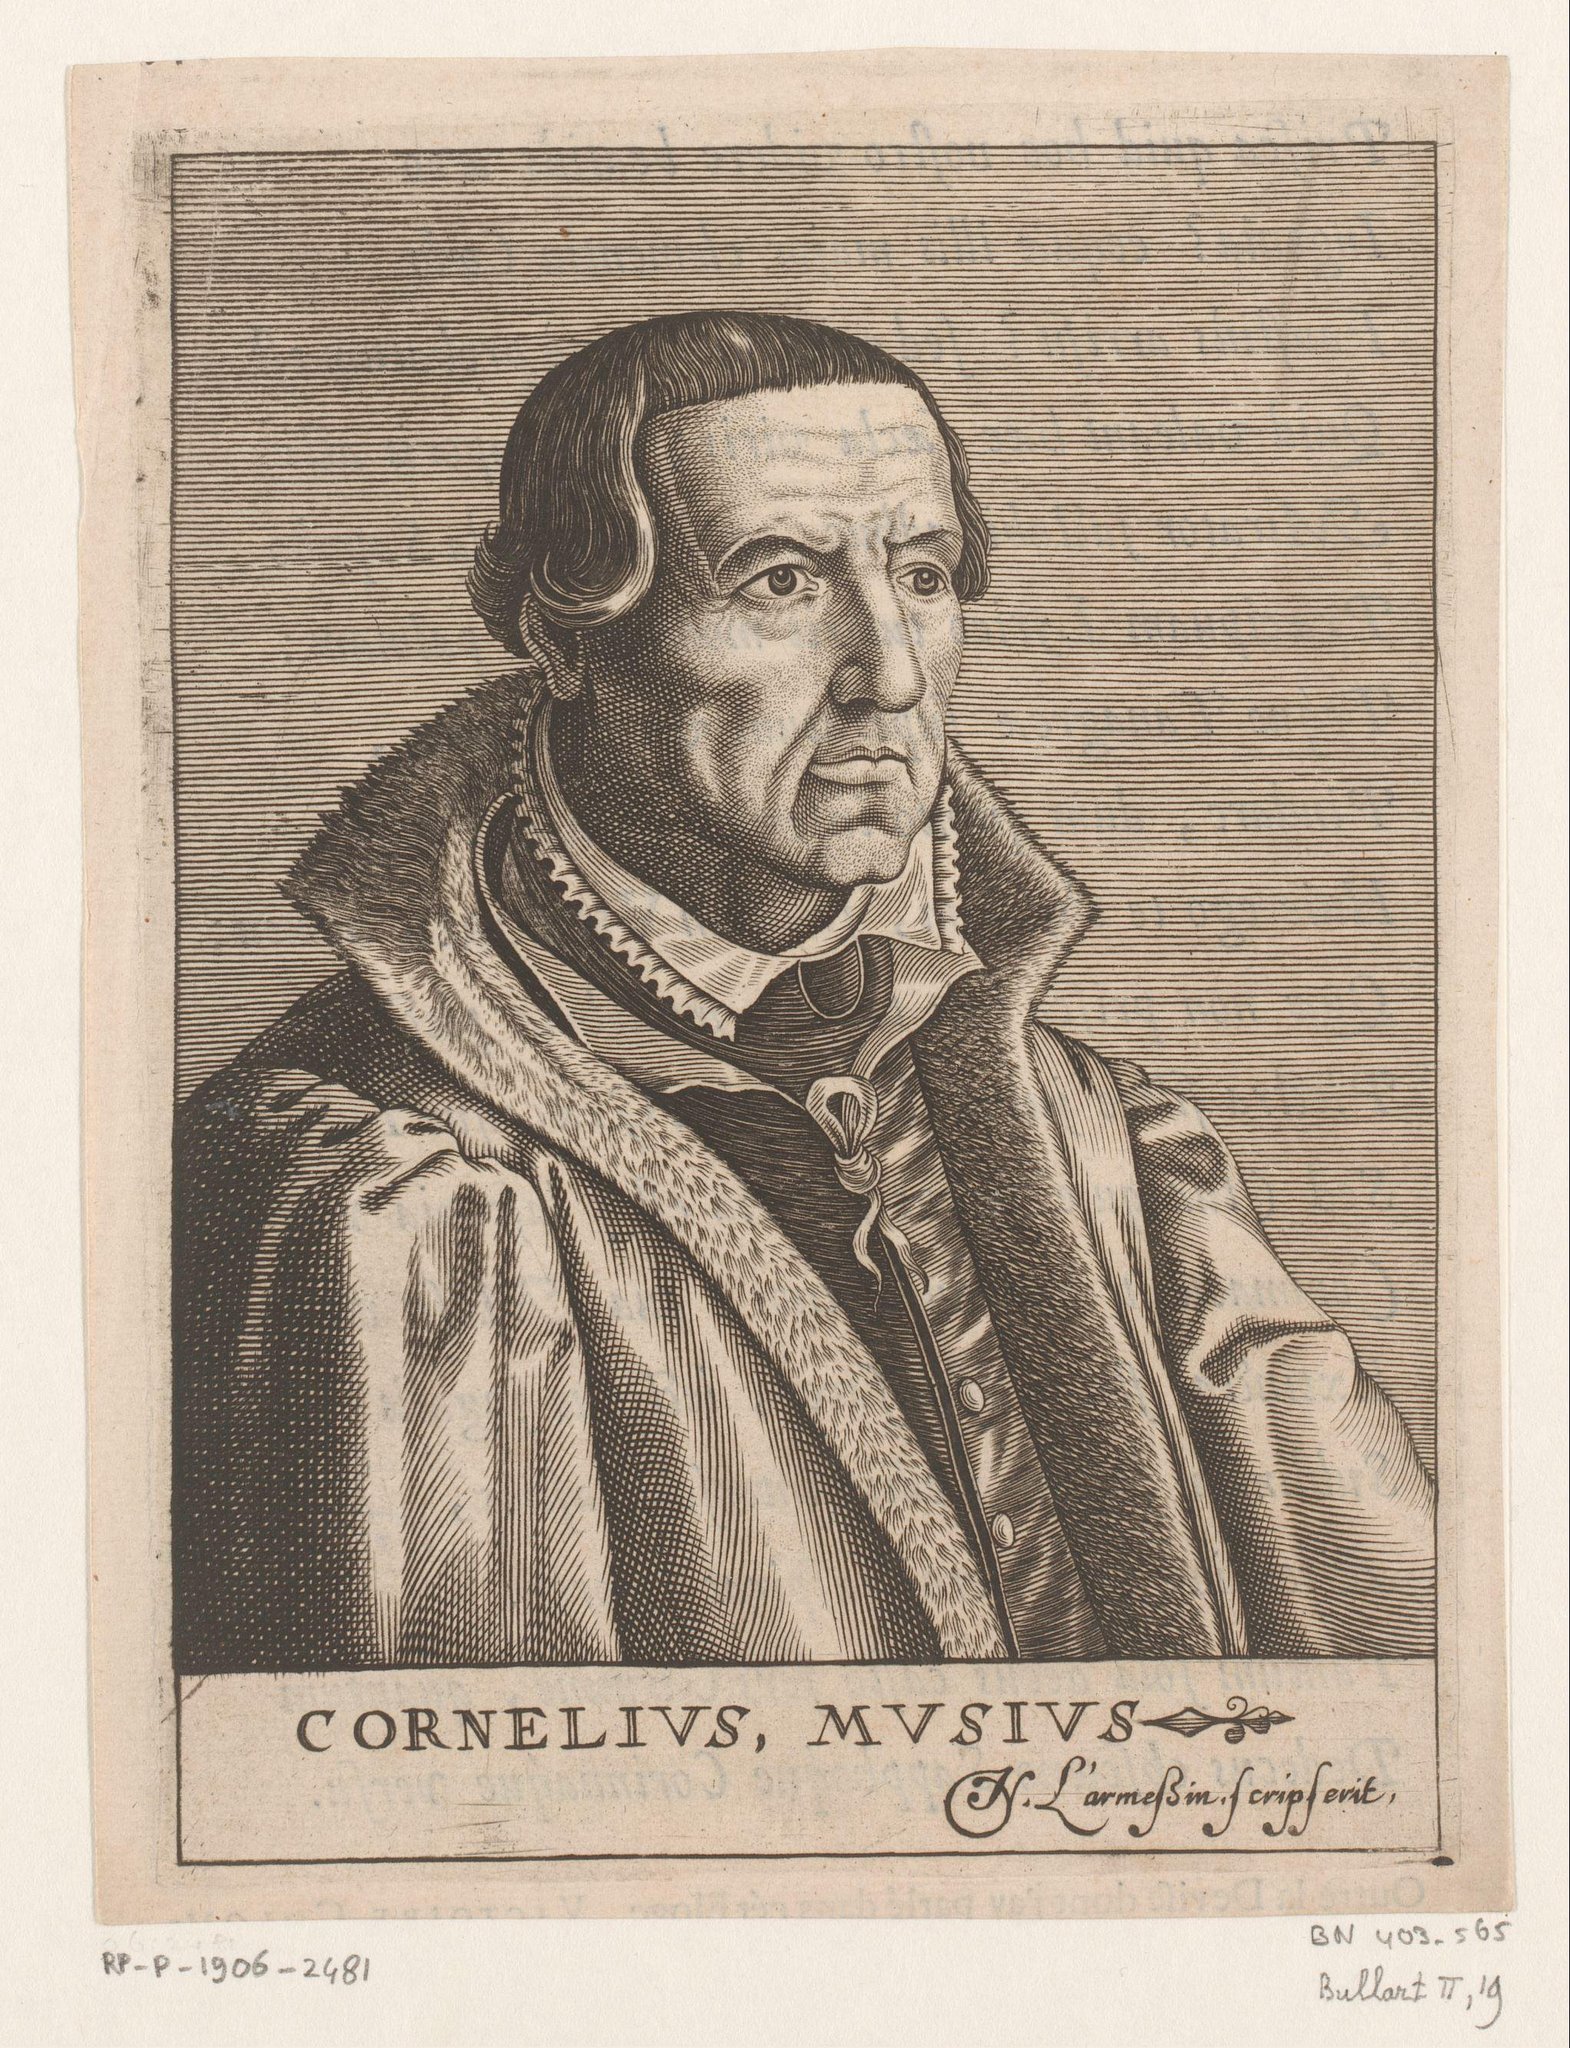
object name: print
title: Portret van Cornelis Musius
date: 1682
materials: paper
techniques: engraving, letterpress printing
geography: brussels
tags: delft, leiden, priest, cornelis musius, historical persons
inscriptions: collector's mark: Lugt 2228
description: Prent gebruikt voor: Bullart, Isaac. Académie des Sciences et Arts contenant les vies et éloges his. des hommes illustres qui ont excellé en ces professions depuis environ quatre siècles. Brussel: François Foppens, 1682. Het boek werd in 1682 eveneens in Amsterdam uitgegeven door de erfgenamen van Daniel Elzevier. Ieder portret betreft een illustratie bij de biografie van een kunstenaar of geleerde. De meeste portretten werden door Nicolas de Larmessin vervaardigd (162), 93 door De Boulonois en een derde door ongeïdentificeerde prentmakers. Dit betreft een illustratie op p. 340, deel II.